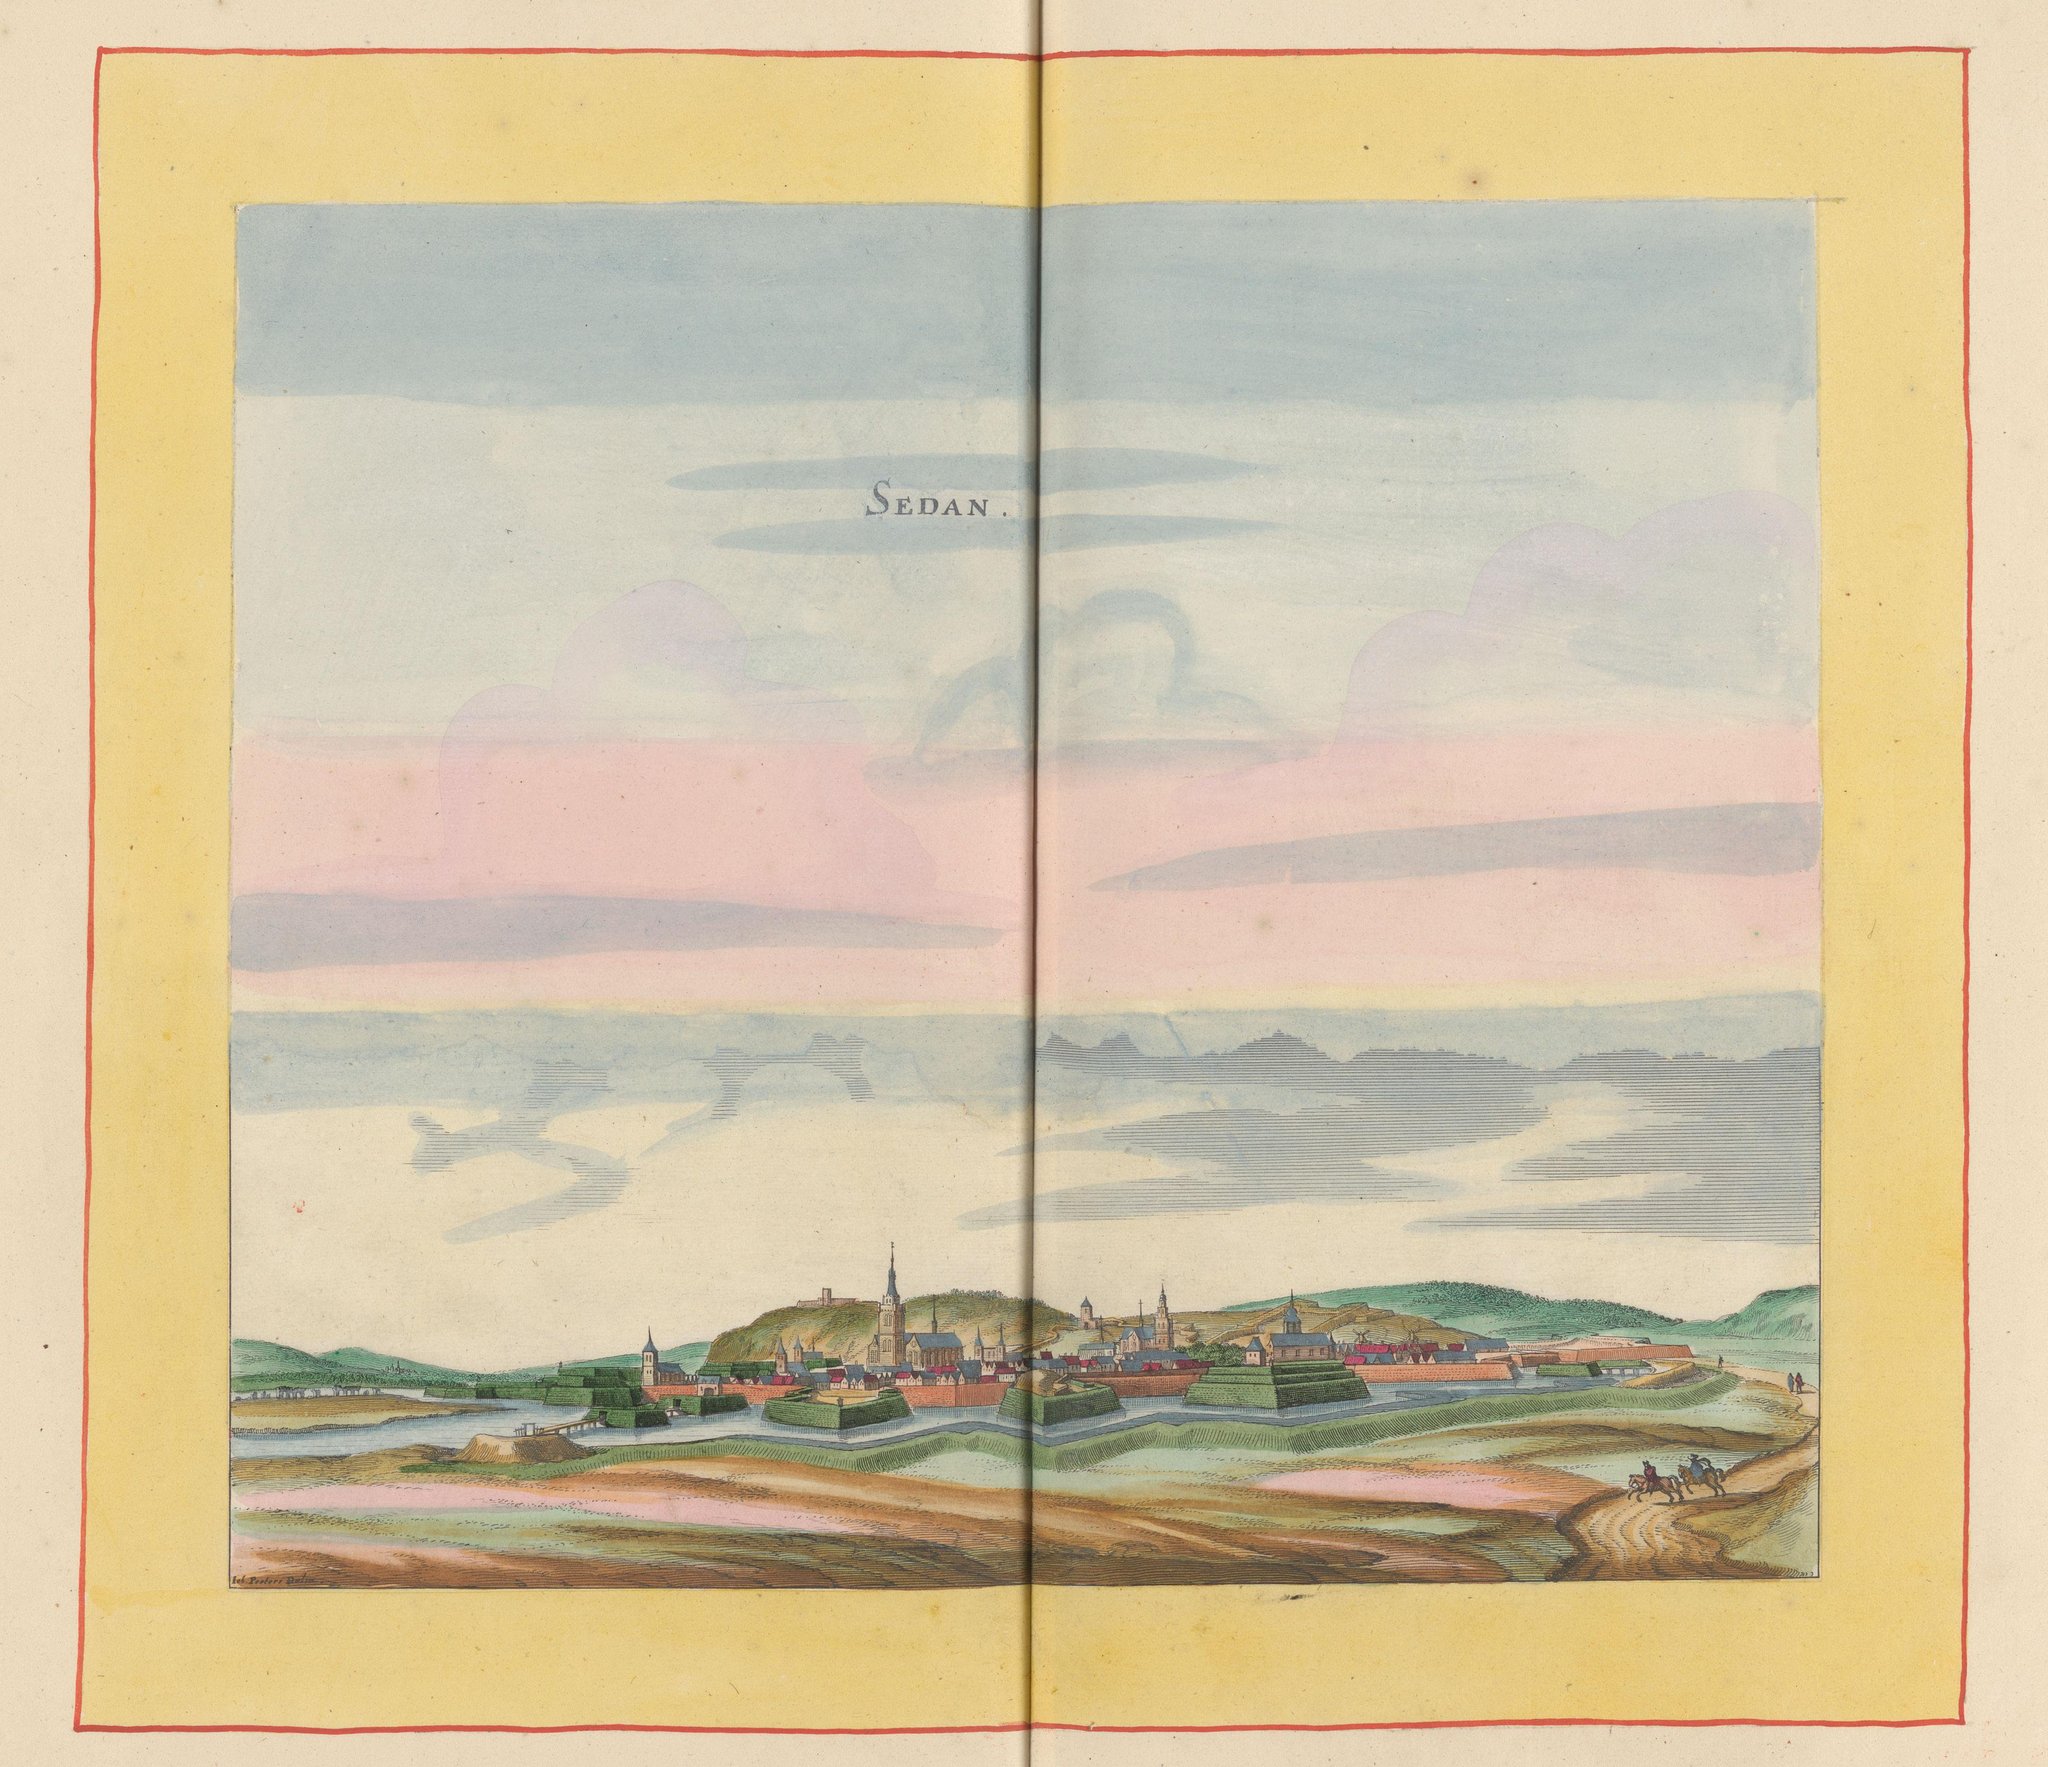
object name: album leaf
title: Gezicht op Sedan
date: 1656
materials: paper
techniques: engraving, etching, hand coloring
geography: frankfurt am main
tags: city-view in general; 'veduta'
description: Prent uit: Zeiller, Martin. Topographia Galliae. 13 dln. Frankfurt: Caspar Merian, 1656, dl. 3, na p. 30. Origineel op één blad gedrukt met een gezicht op Toul (RP-P-1957-607-182).